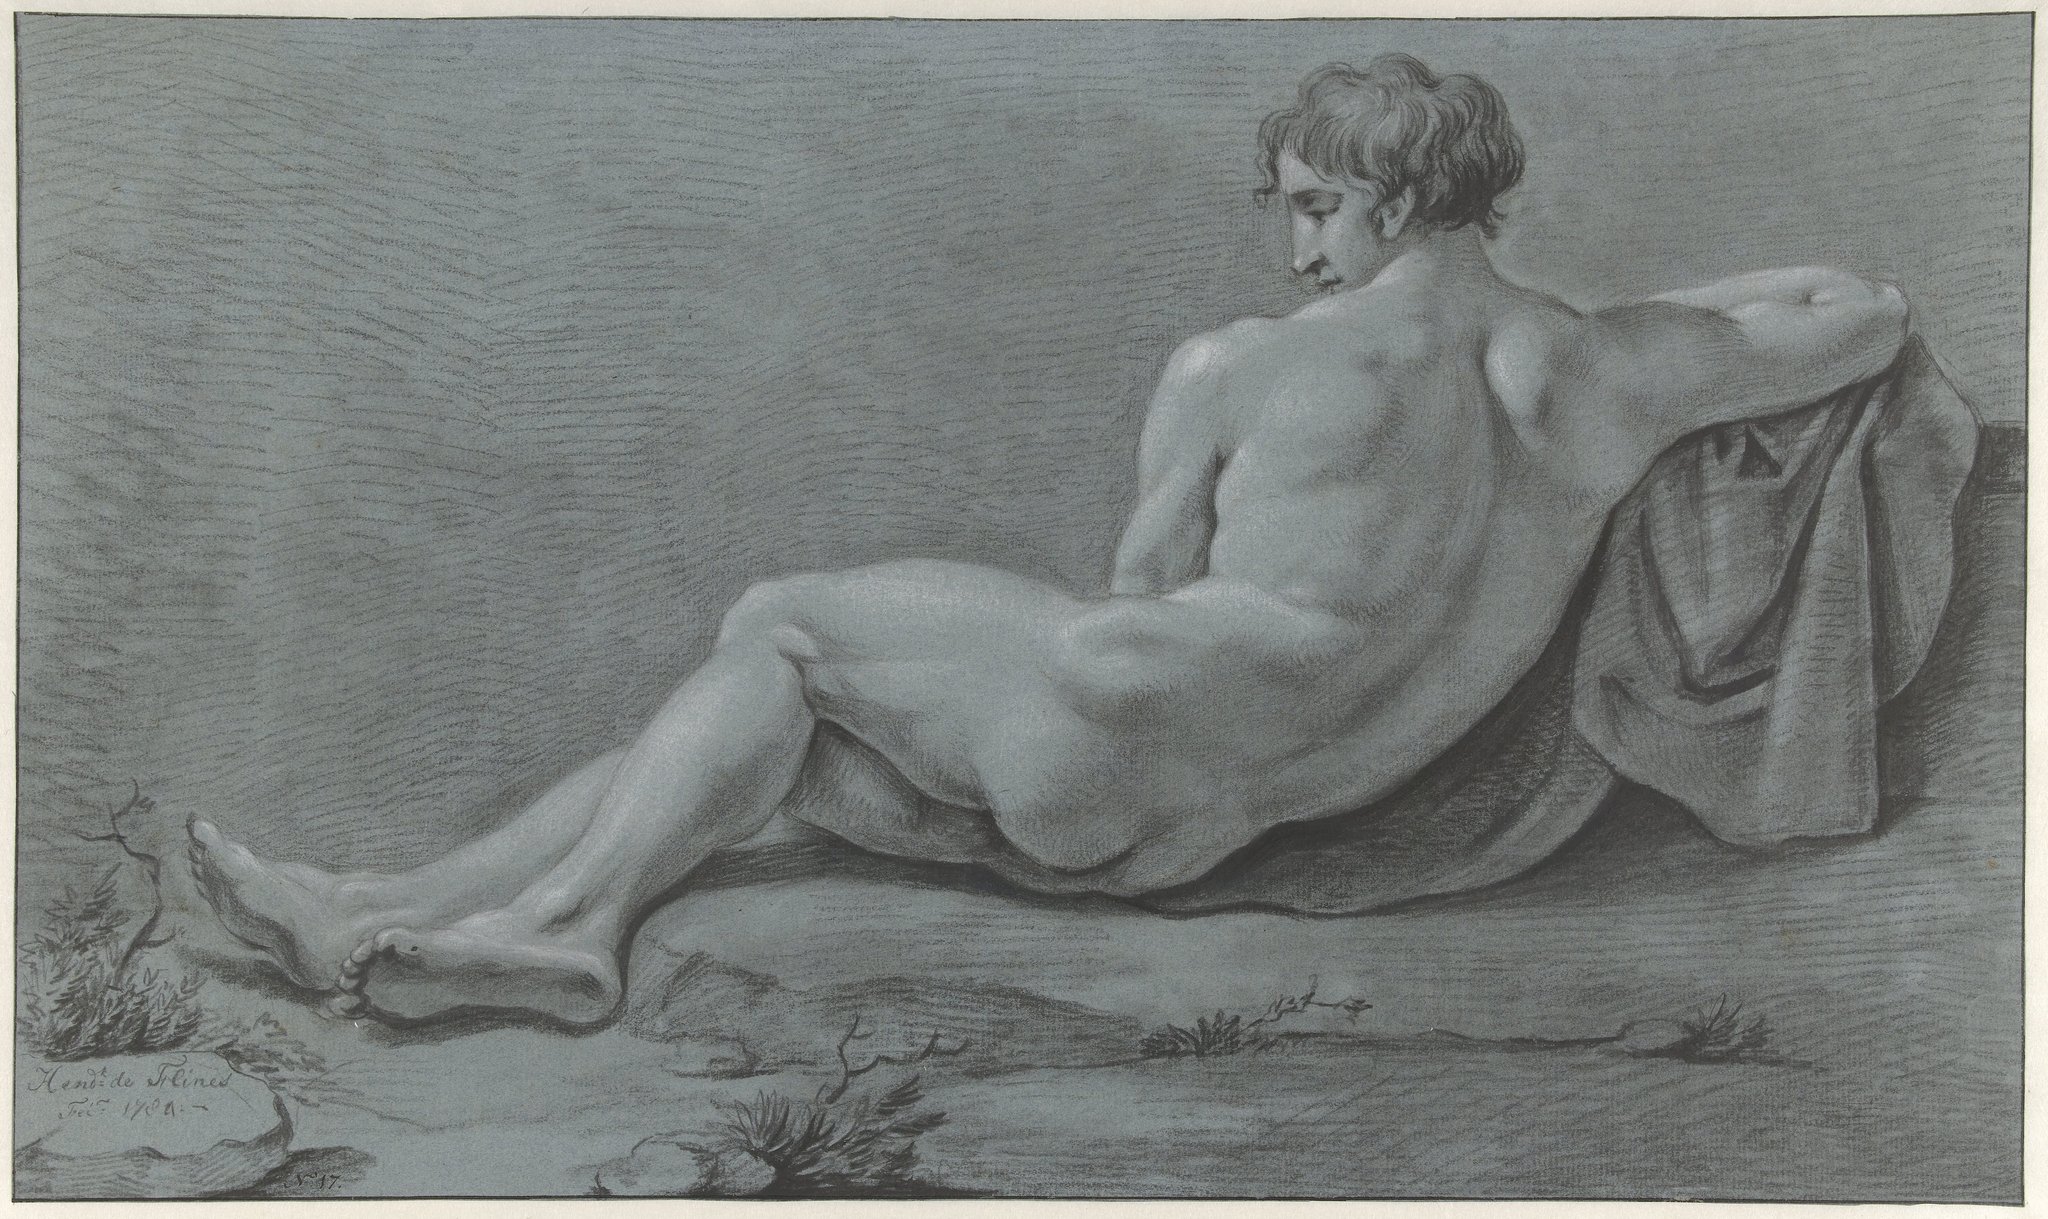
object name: drawing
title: Liggend mannelijk naakt, op de rug gezien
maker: hendrik de flines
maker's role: draughtsman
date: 1780-1789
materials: chalk, paper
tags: lying figure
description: Liggend mannelijk naakt, op de rug gezien. No. 17.